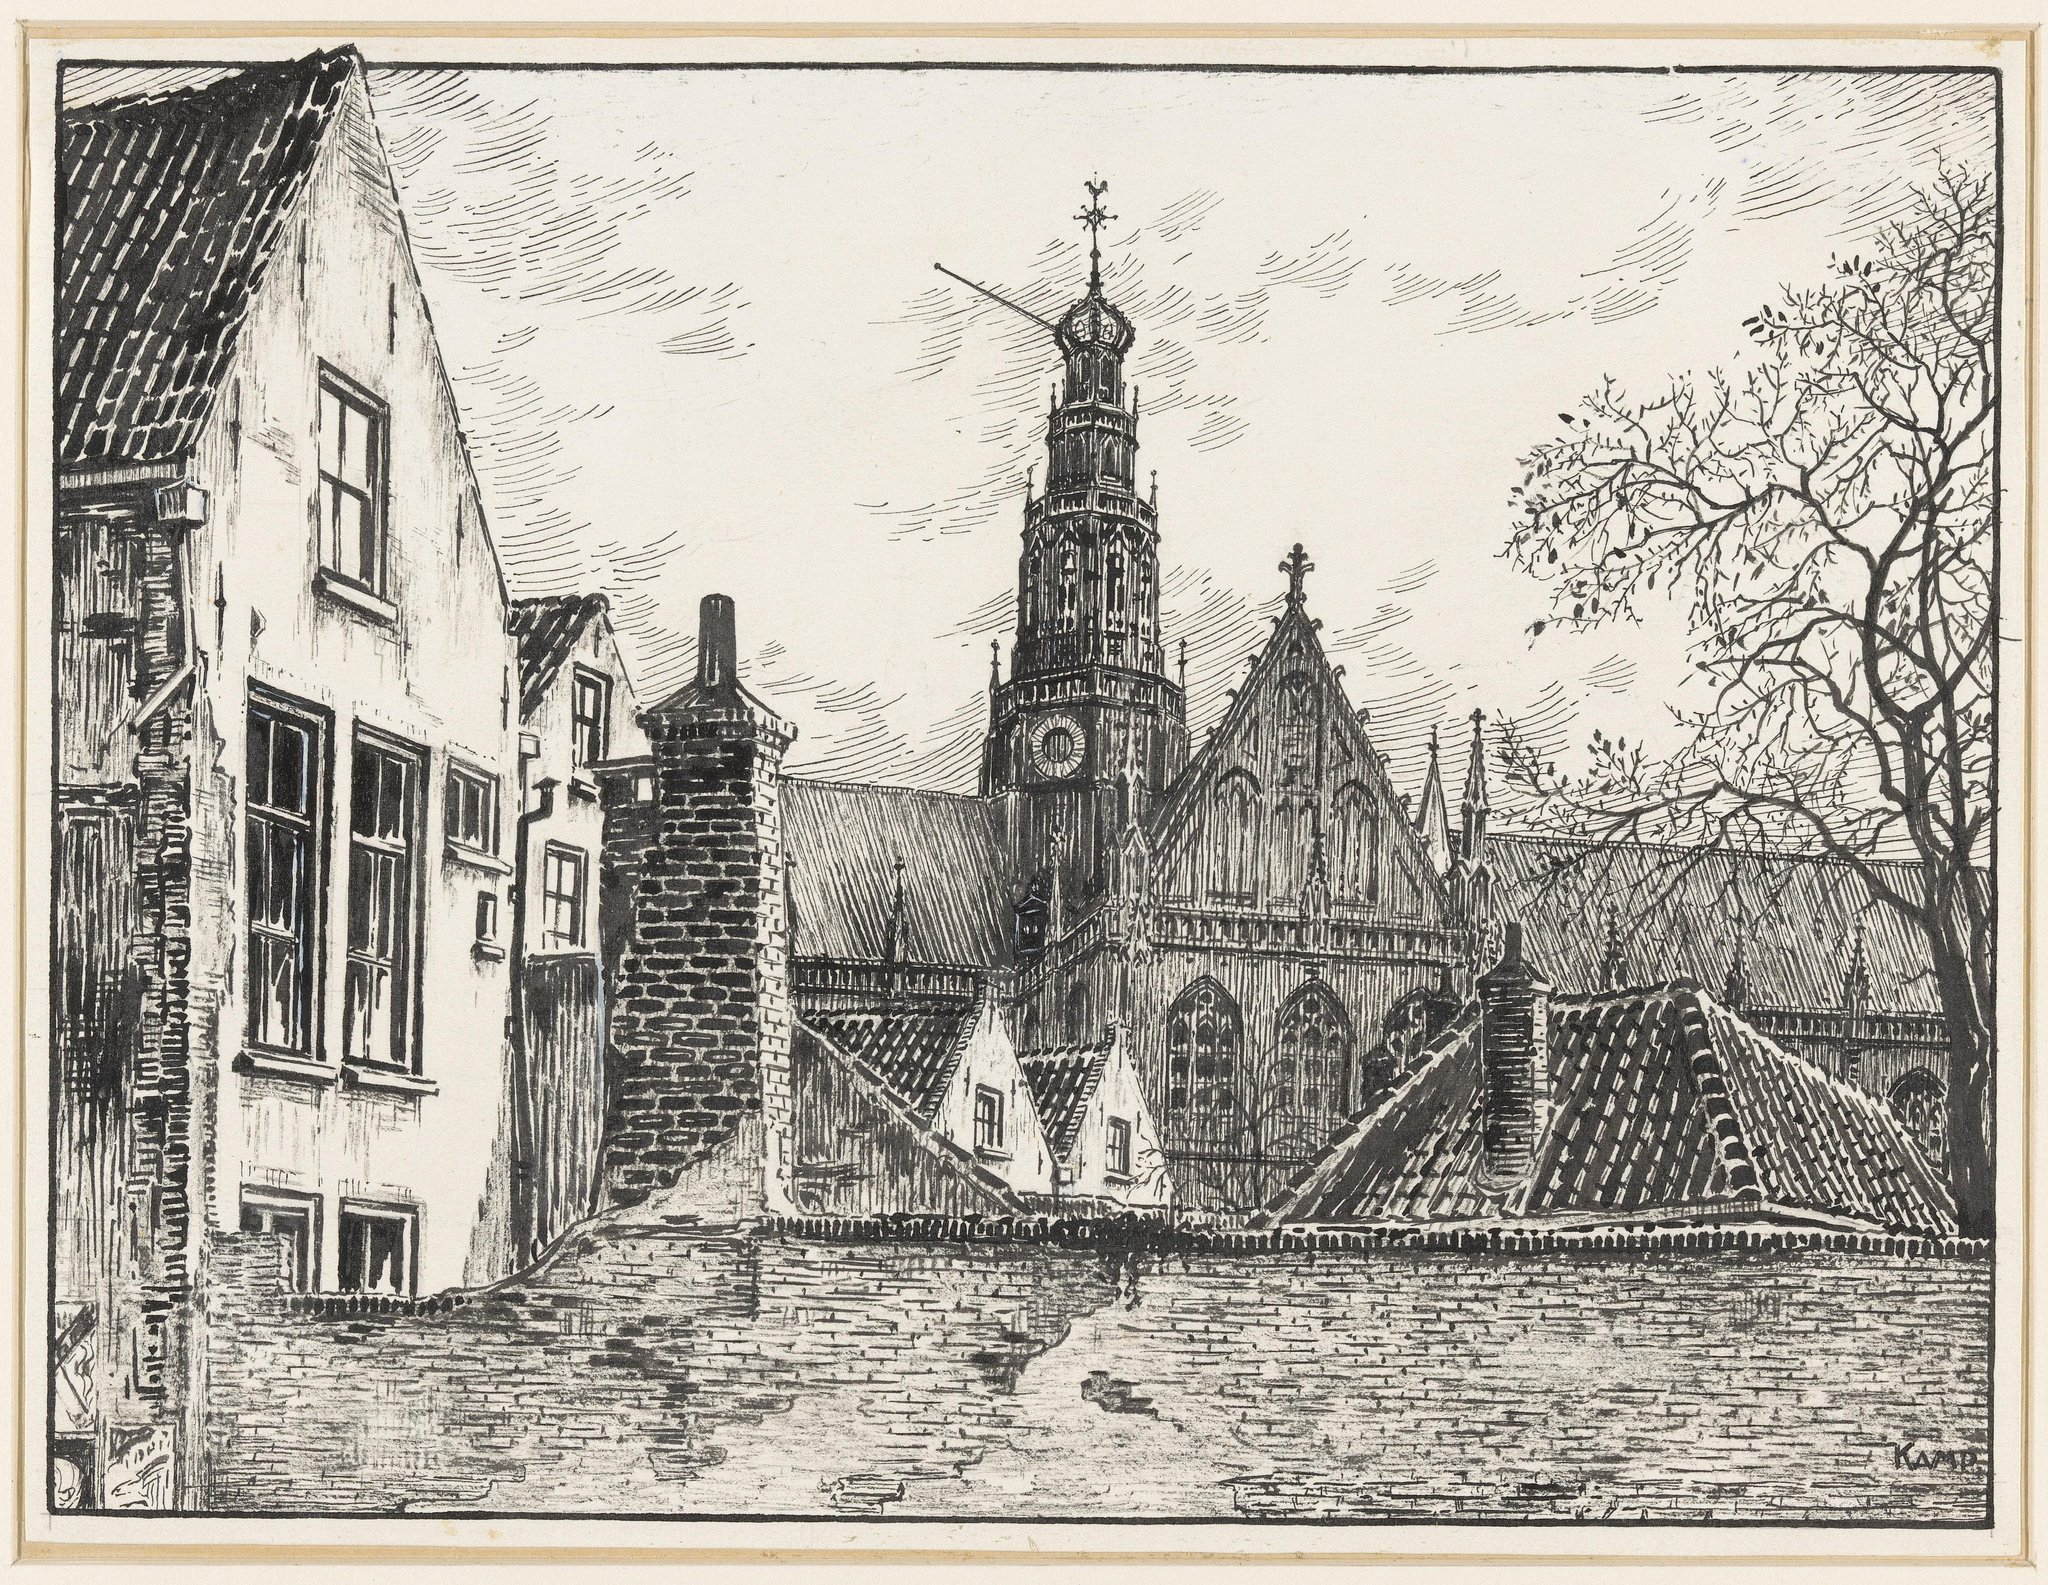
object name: drawing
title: Gezicht op de Sint Bavokerk in Haarlem, gezien vanuit de Schoolsteeg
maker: johan bernhard kamp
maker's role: draughtsman, print maker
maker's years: 1884-1953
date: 1894-1943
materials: paint, ink, paper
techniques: brush, pen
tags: roof (of house or building), church (exterior)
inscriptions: inscription: ‘1’, collector's mark: Lugt 2228